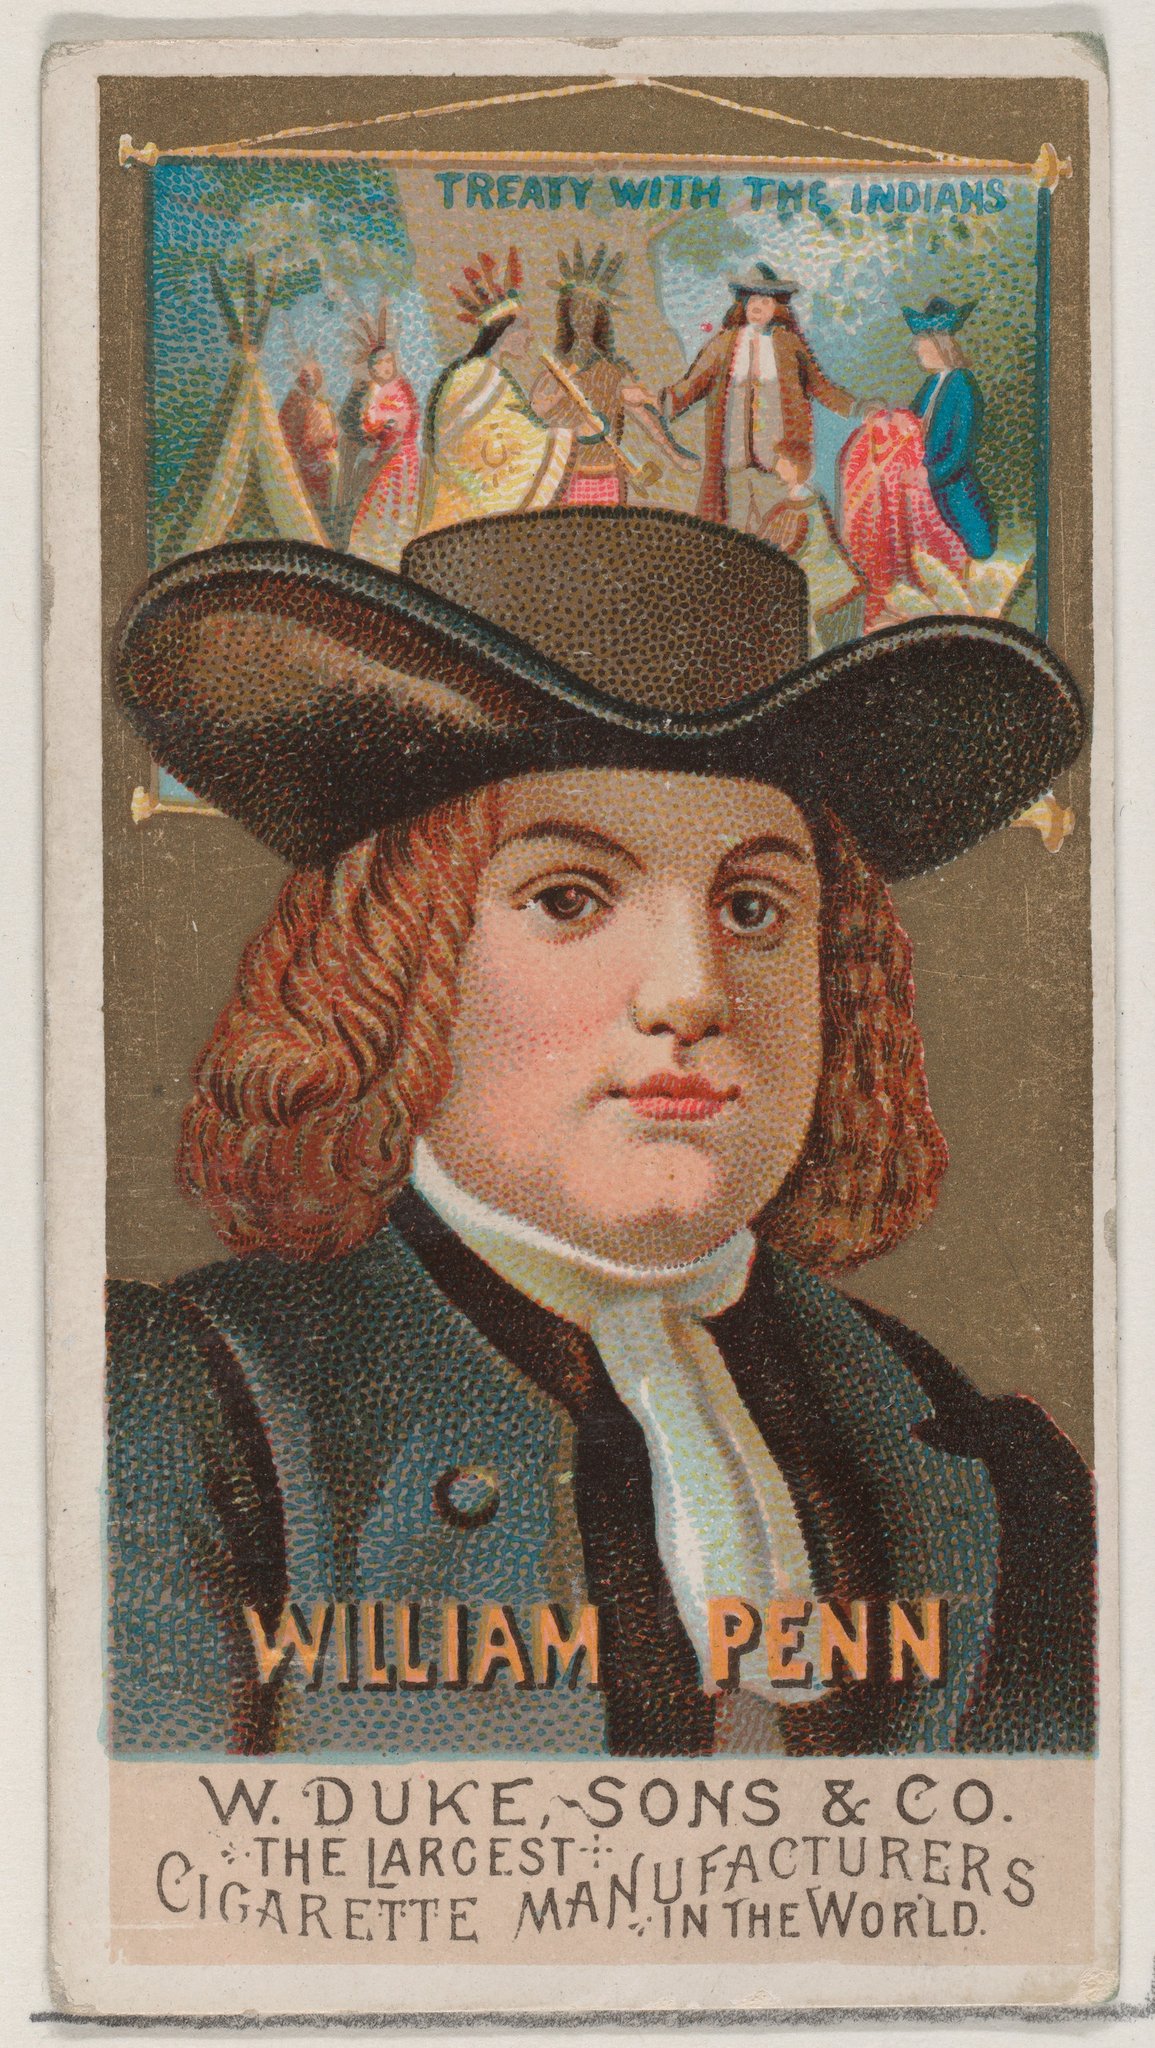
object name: print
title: William Penn, from the series Great Americans (N76) for Duke brand cigarettes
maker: w. duke, sons & co.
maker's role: publisher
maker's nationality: american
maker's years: 1870-1920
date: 1888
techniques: color lithograph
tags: men